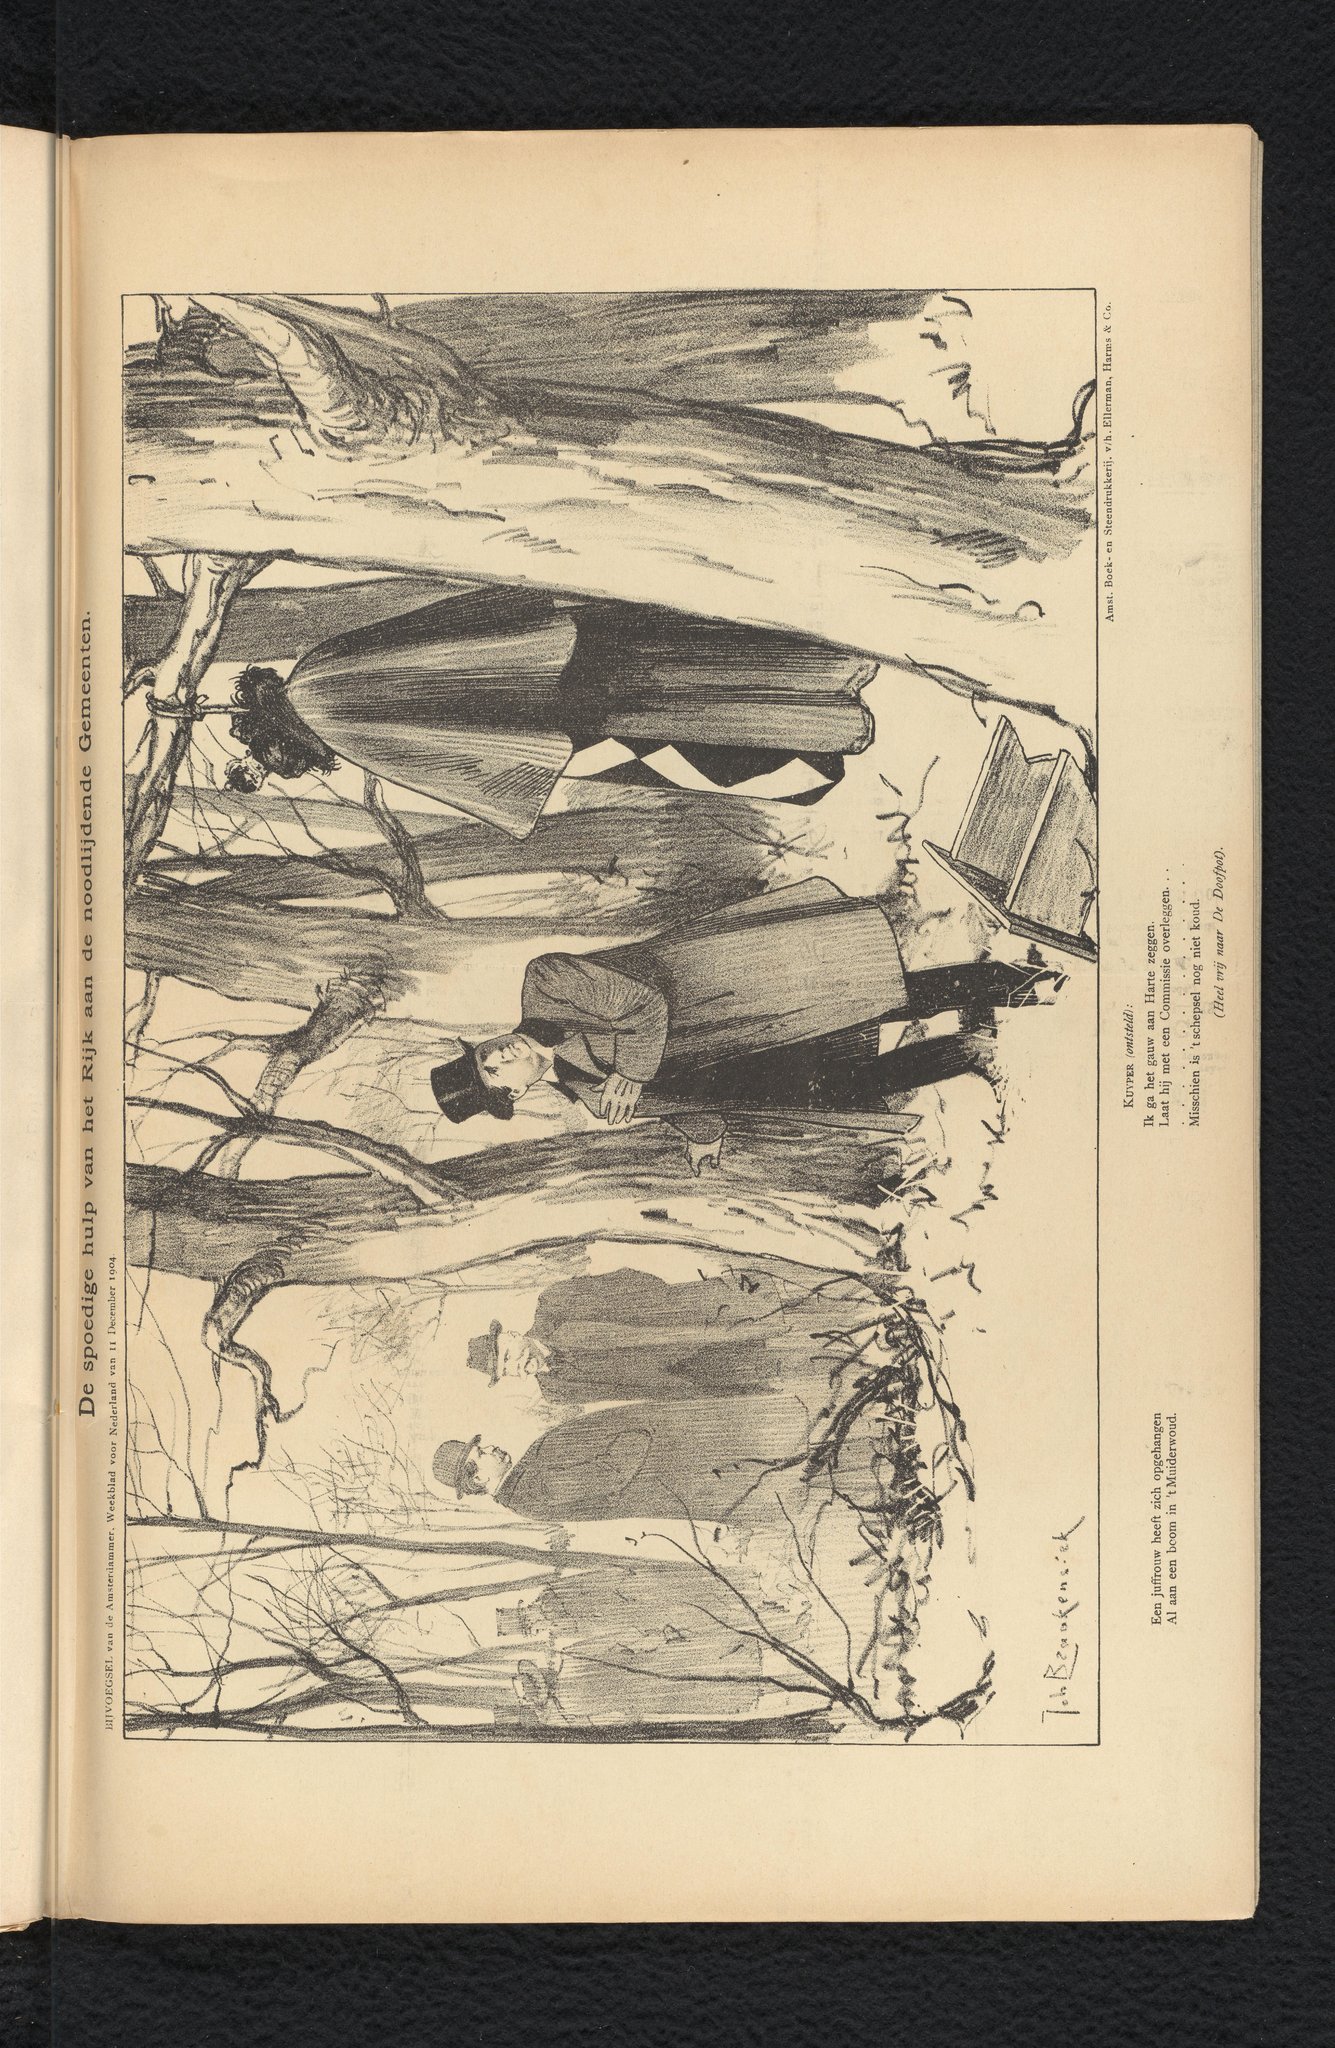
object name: cartoon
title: De spoedige hulp van het Rijk aan de noodlijdende Gemeenten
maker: johan braakensiek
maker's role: draughtsman, print maker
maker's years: 1858-1940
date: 1904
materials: paper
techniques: lithograph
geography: netherlands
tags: the hague, abraham kuyper, personification of a city, town-patron(ess), violent death by hanging, seeking death, suicide, municipal government, political caricatures and satires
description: Premier Kuyper ontstelt bij het aantreffen van het lijk van de stadsmaagd van Amsterdam, die zich aan een boom in het bos heeft opgehangen. Vanwege het achterwege blijven van overheidssteun aan de gemeenten.